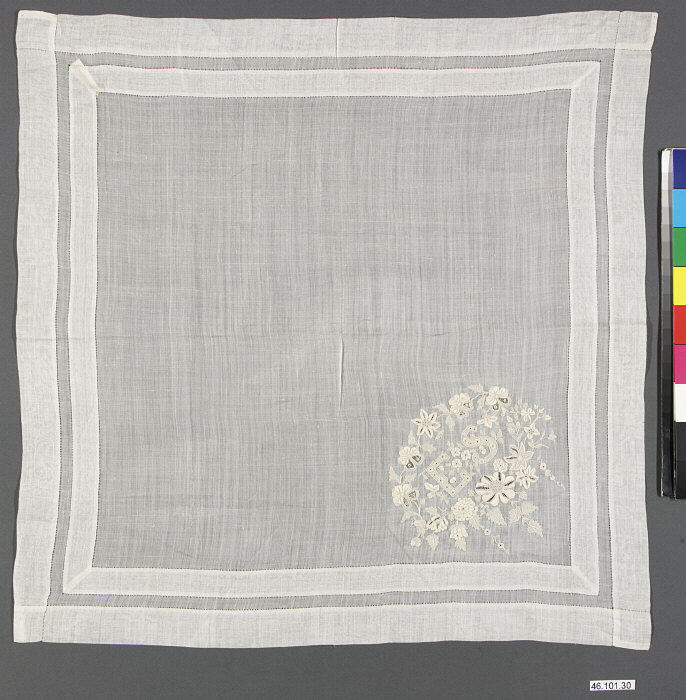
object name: handkerchief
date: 1851-1875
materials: linen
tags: flowers